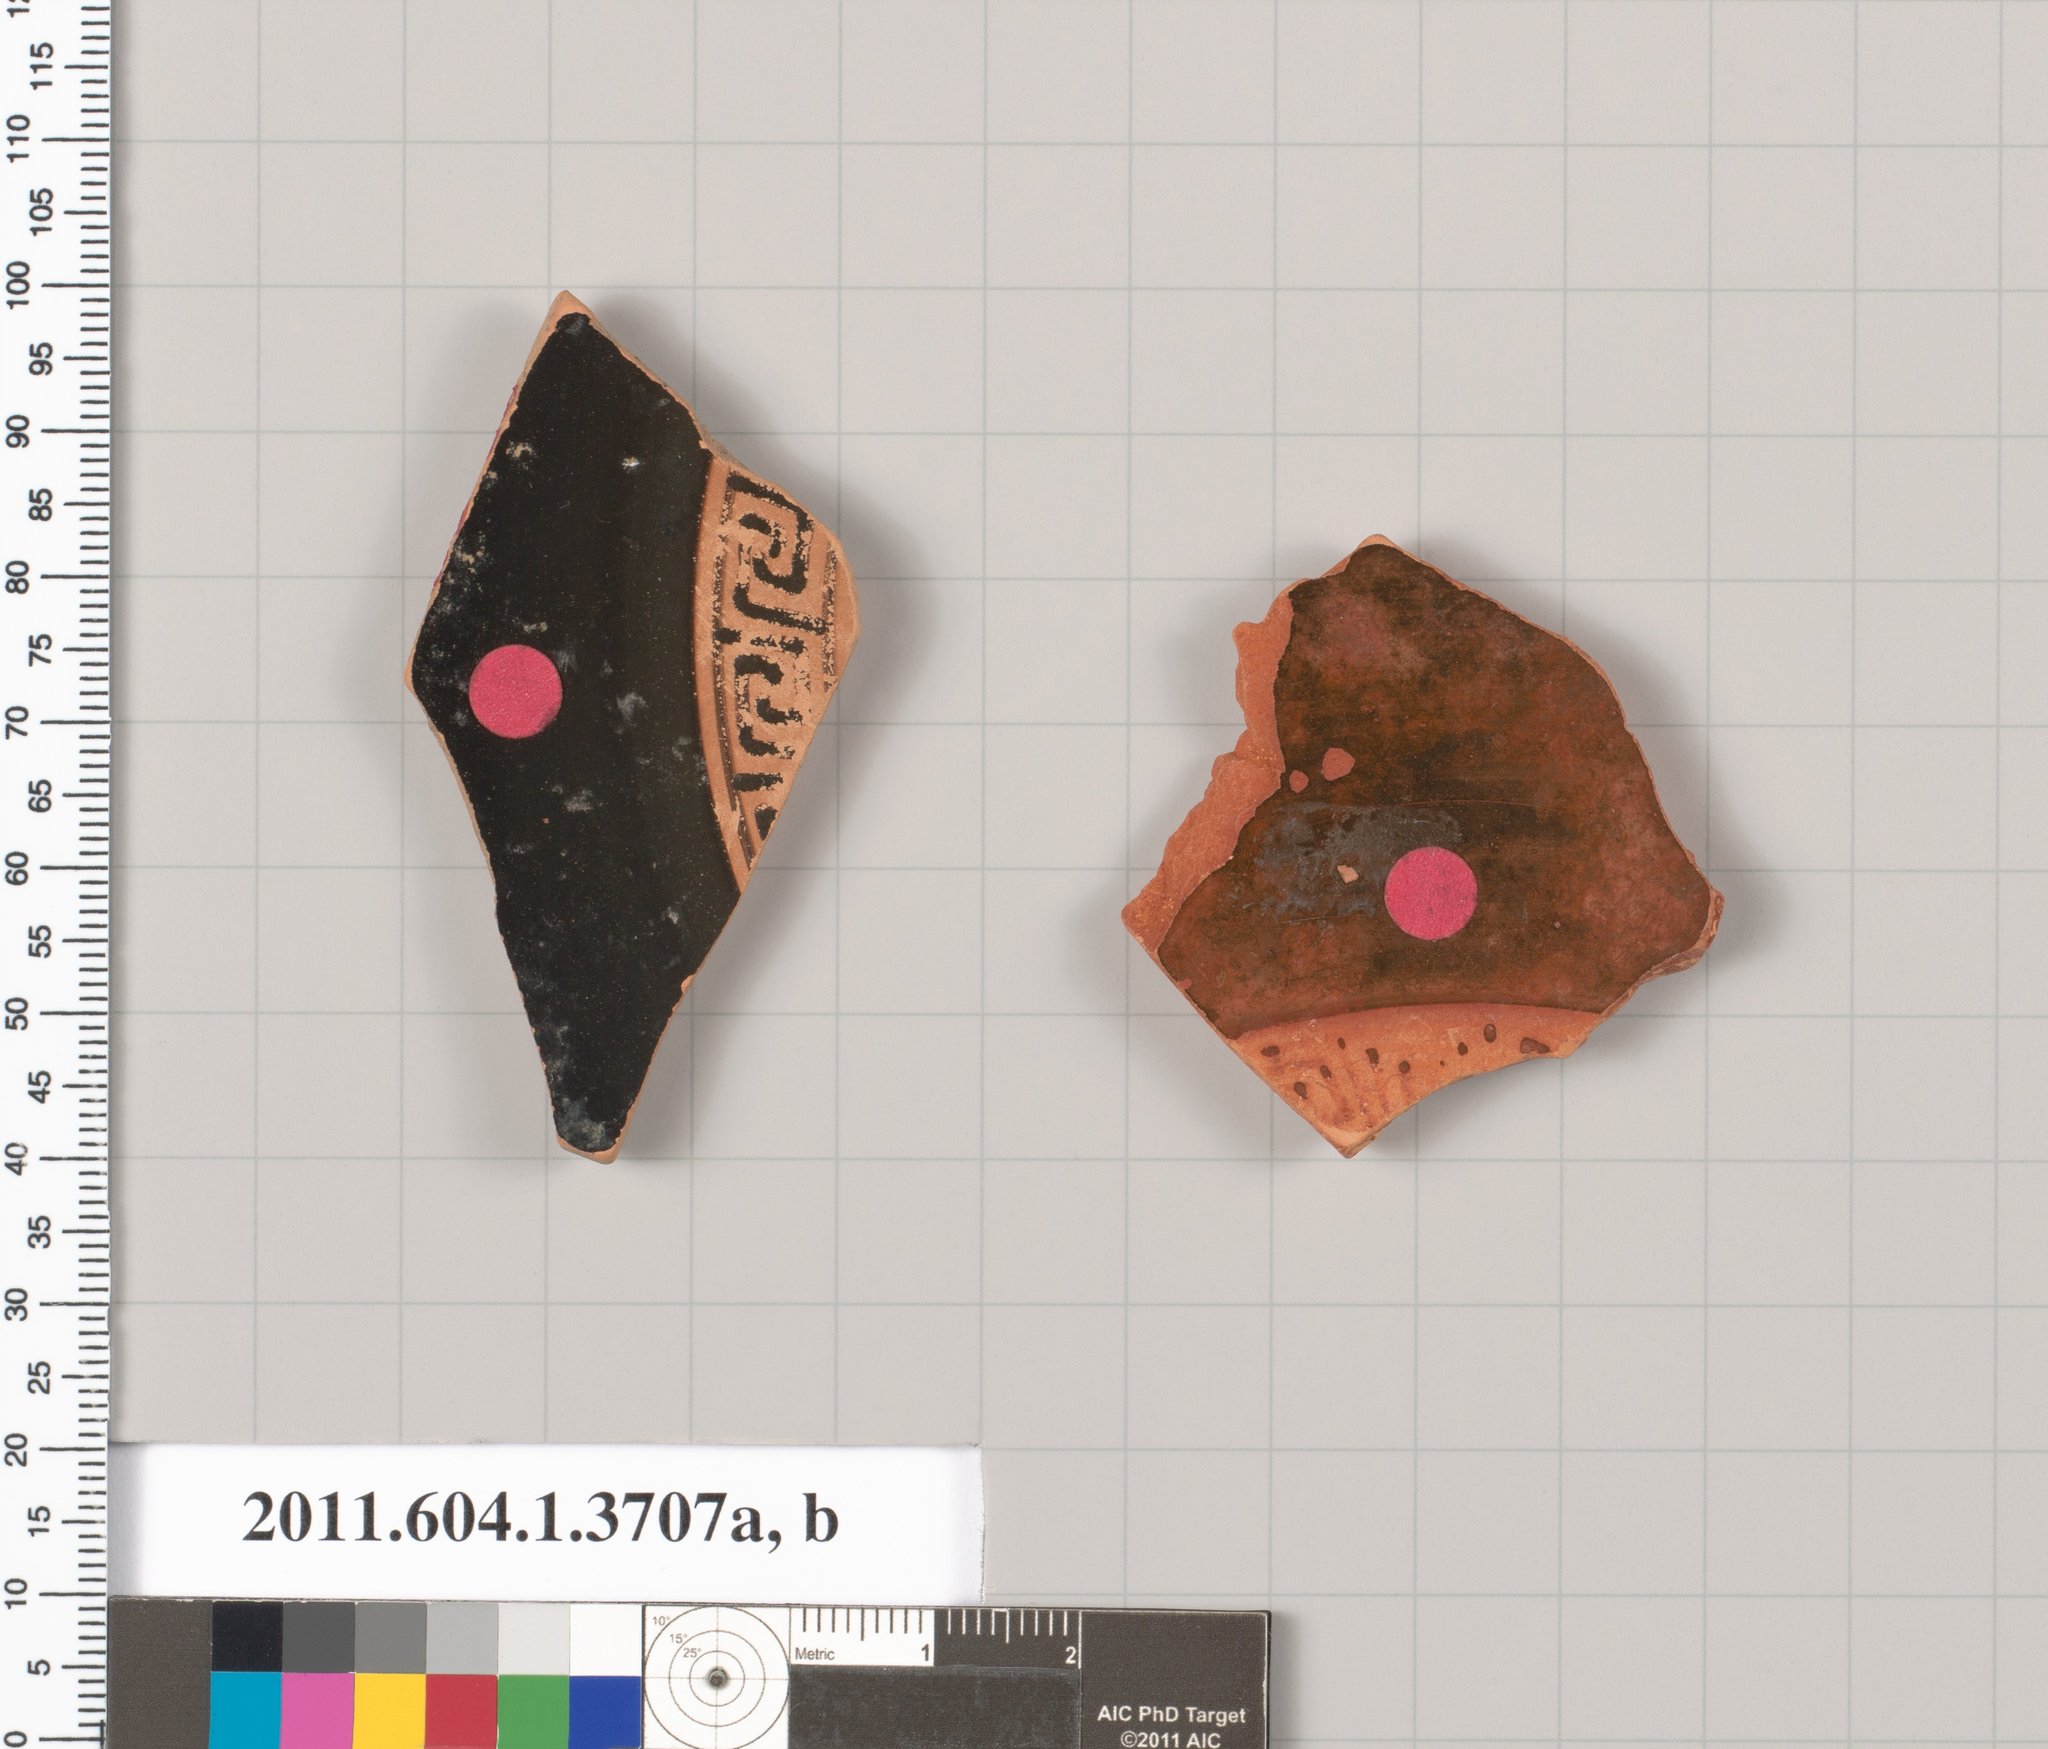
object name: kylix fragment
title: Terracotta fragments of kylikes (drinking cups)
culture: greek, attic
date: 470-460 BCE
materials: terracotta